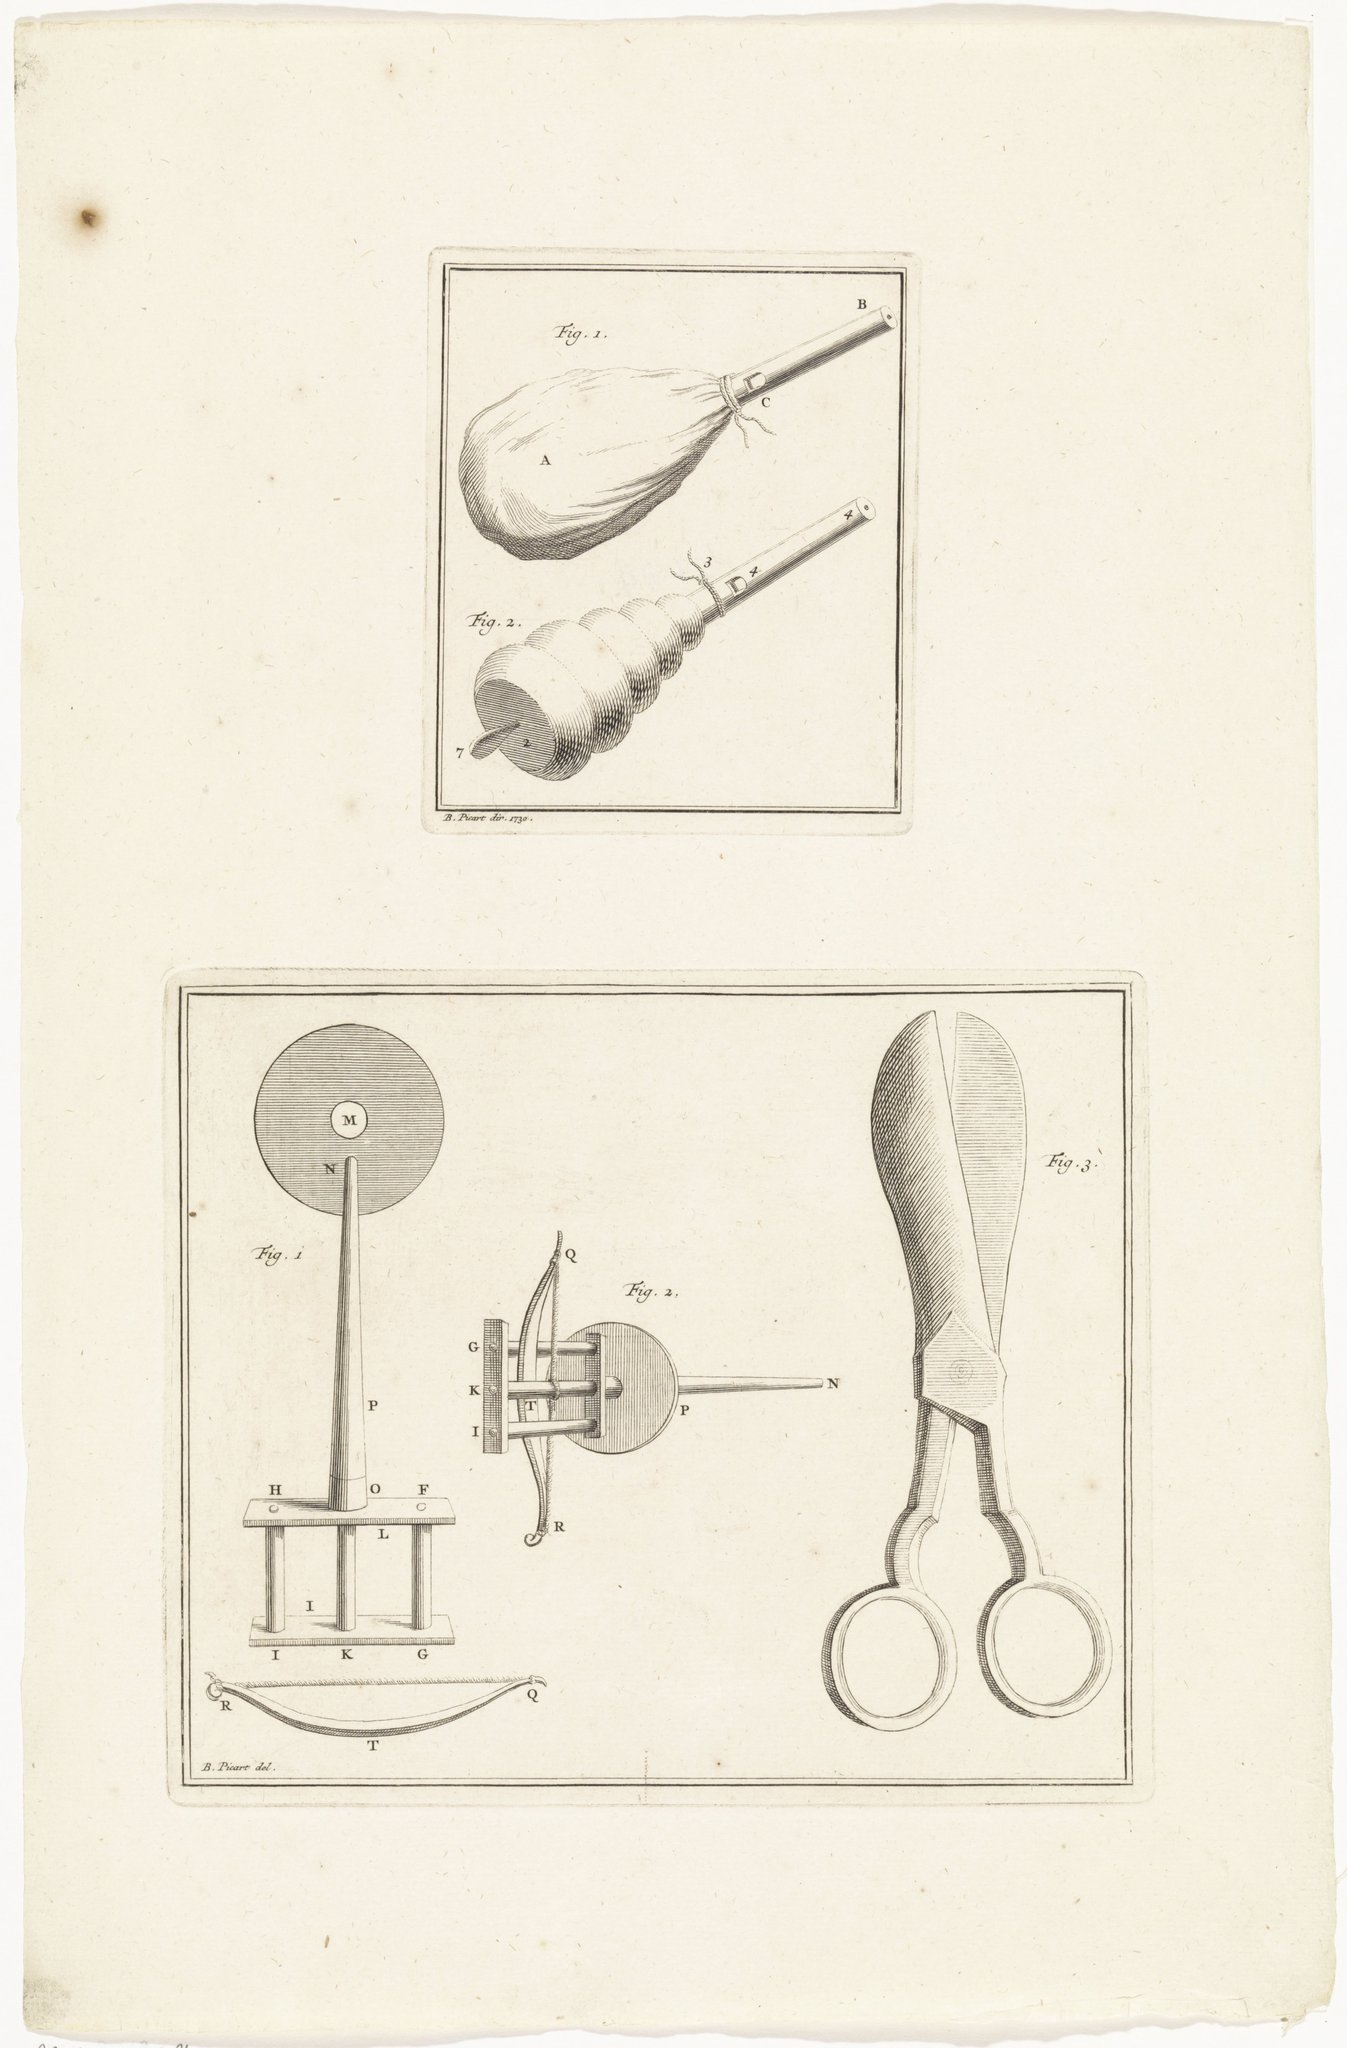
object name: print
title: Instrumenten en een schaar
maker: bernard picart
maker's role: draughtsman, print maker, publisher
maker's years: 1673-1733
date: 1730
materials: paper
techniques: engraving, etching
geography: amsterdam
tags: tools, implements of craftsman, tools, aids, implements ~ crafts and industries: scissors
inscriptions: collector's mark: Lugt 2233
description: Prenten bedoeld voor: Chomel, Noel. Dictionnaire oeconomique, contenant divers moïens d'augmenter son bien, et de conserver sa santé. Amsterdam: Johannes Covens en Cornelis Mortier, 1732.